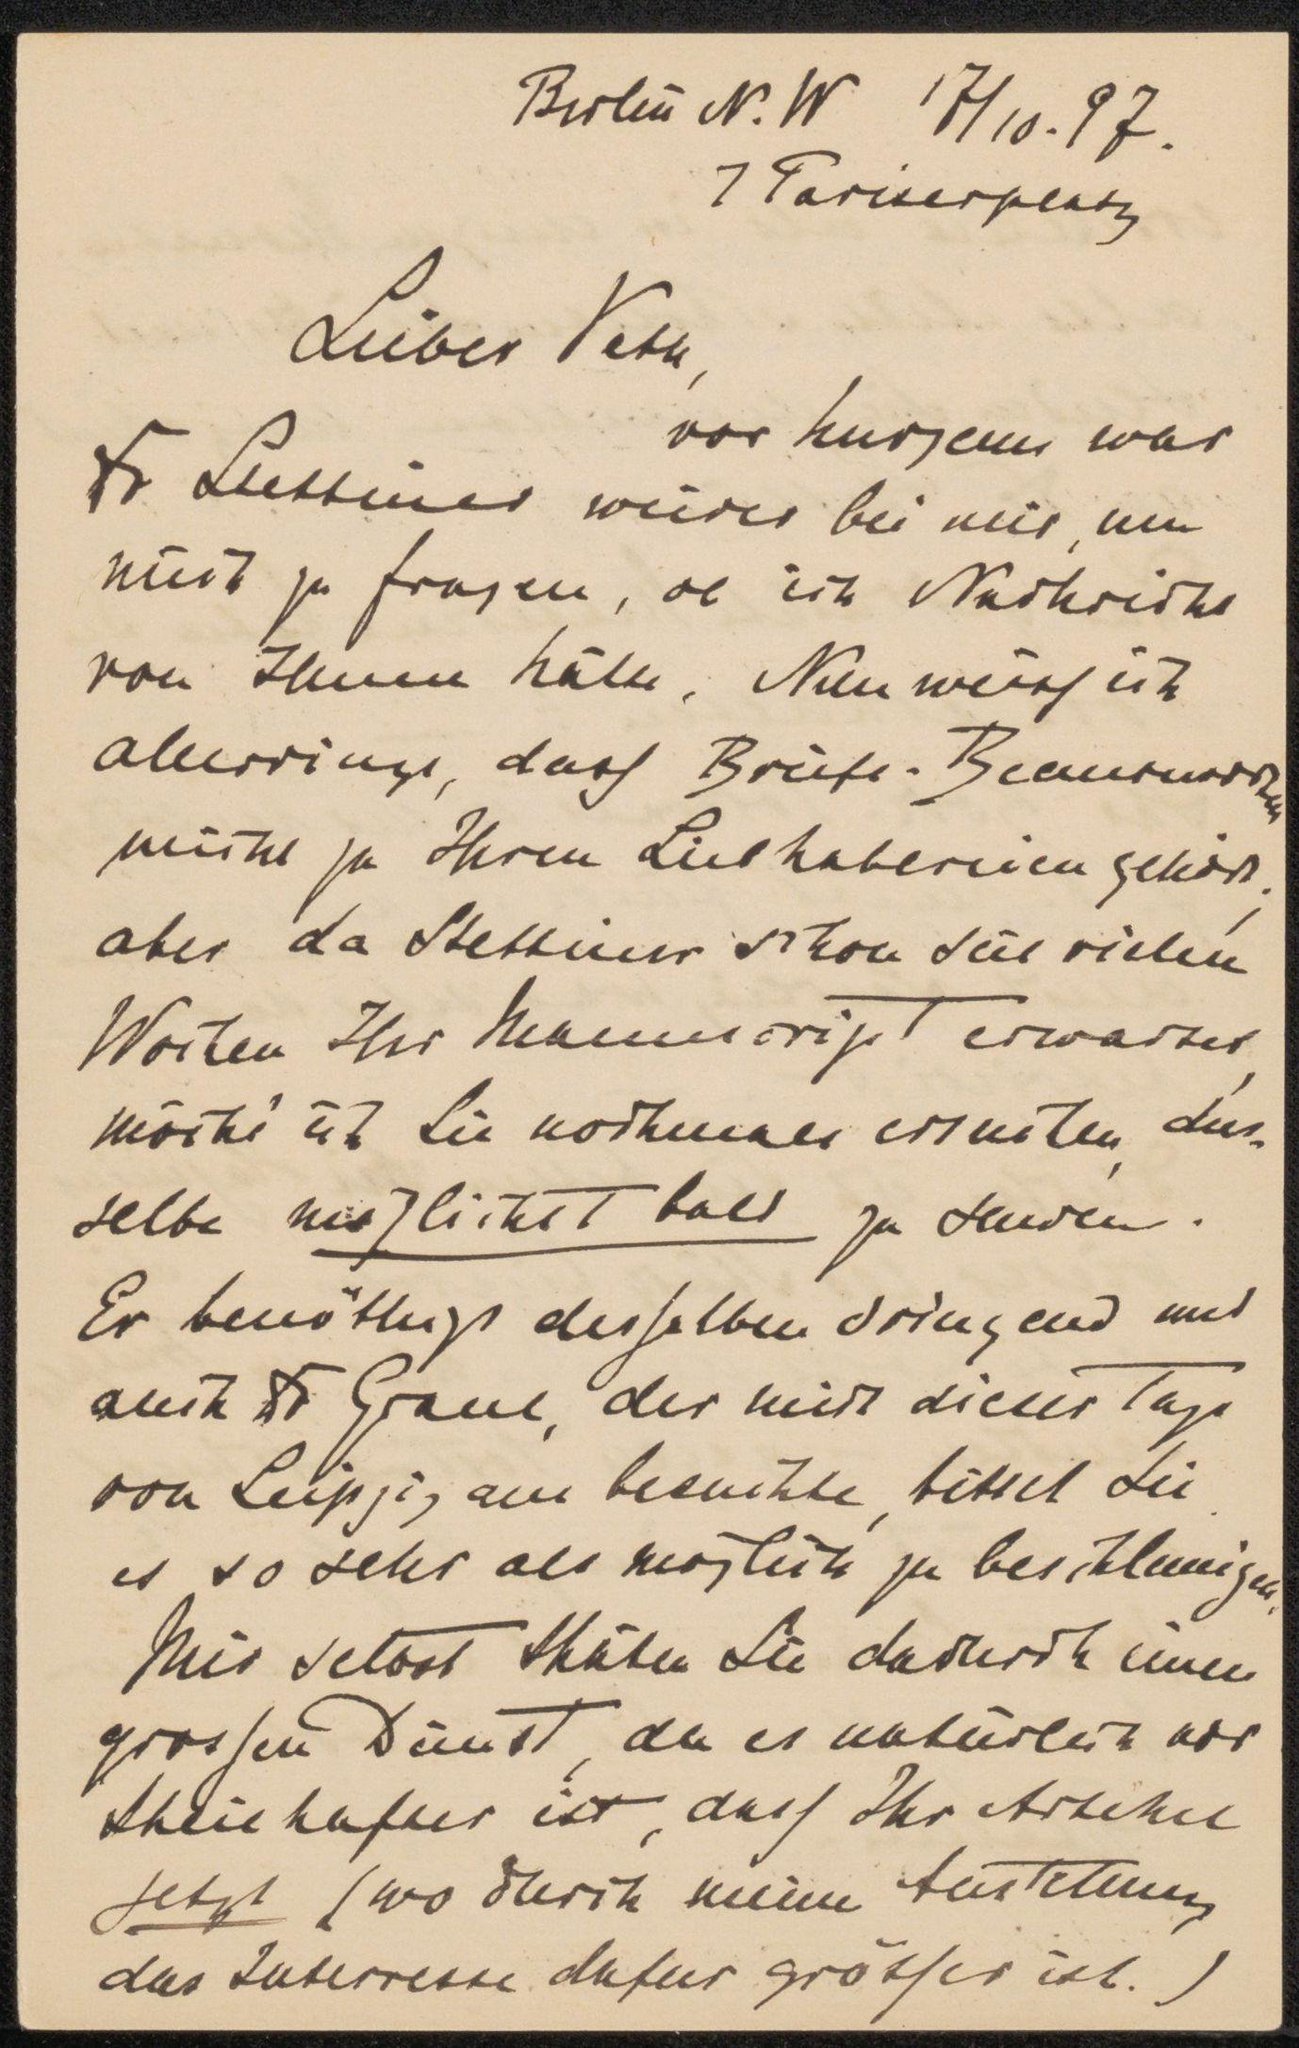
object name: letter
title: Brief aan Jan Veth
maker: max liebermann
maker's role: draughtsman, print maker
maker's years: 1847-1935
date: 1897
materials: ink, paper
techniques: pen, writing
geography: berlin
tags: jozef israëls, jan veth, amsterdam, the hague, painter, print maker, draughtsman, isaac israels, wilhelm von bode, dordrecht, cornelis gerardus 't hooft, richard graul, exhibition ~ art, printed matter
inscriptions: watermark, collector's mark: ‘RPK’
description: Opgenomen in: Ernst Braun, Max Liebermann: Briefe 1896-1901, Baden-Baden: Deutscher Wissenschafts-Verlag, 2012, Band 2, p. 154-155.